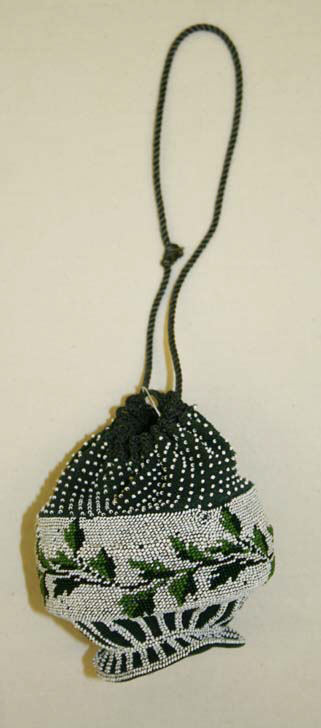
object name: purse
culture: dutch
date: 1810-1820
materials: cotton, glass, silk